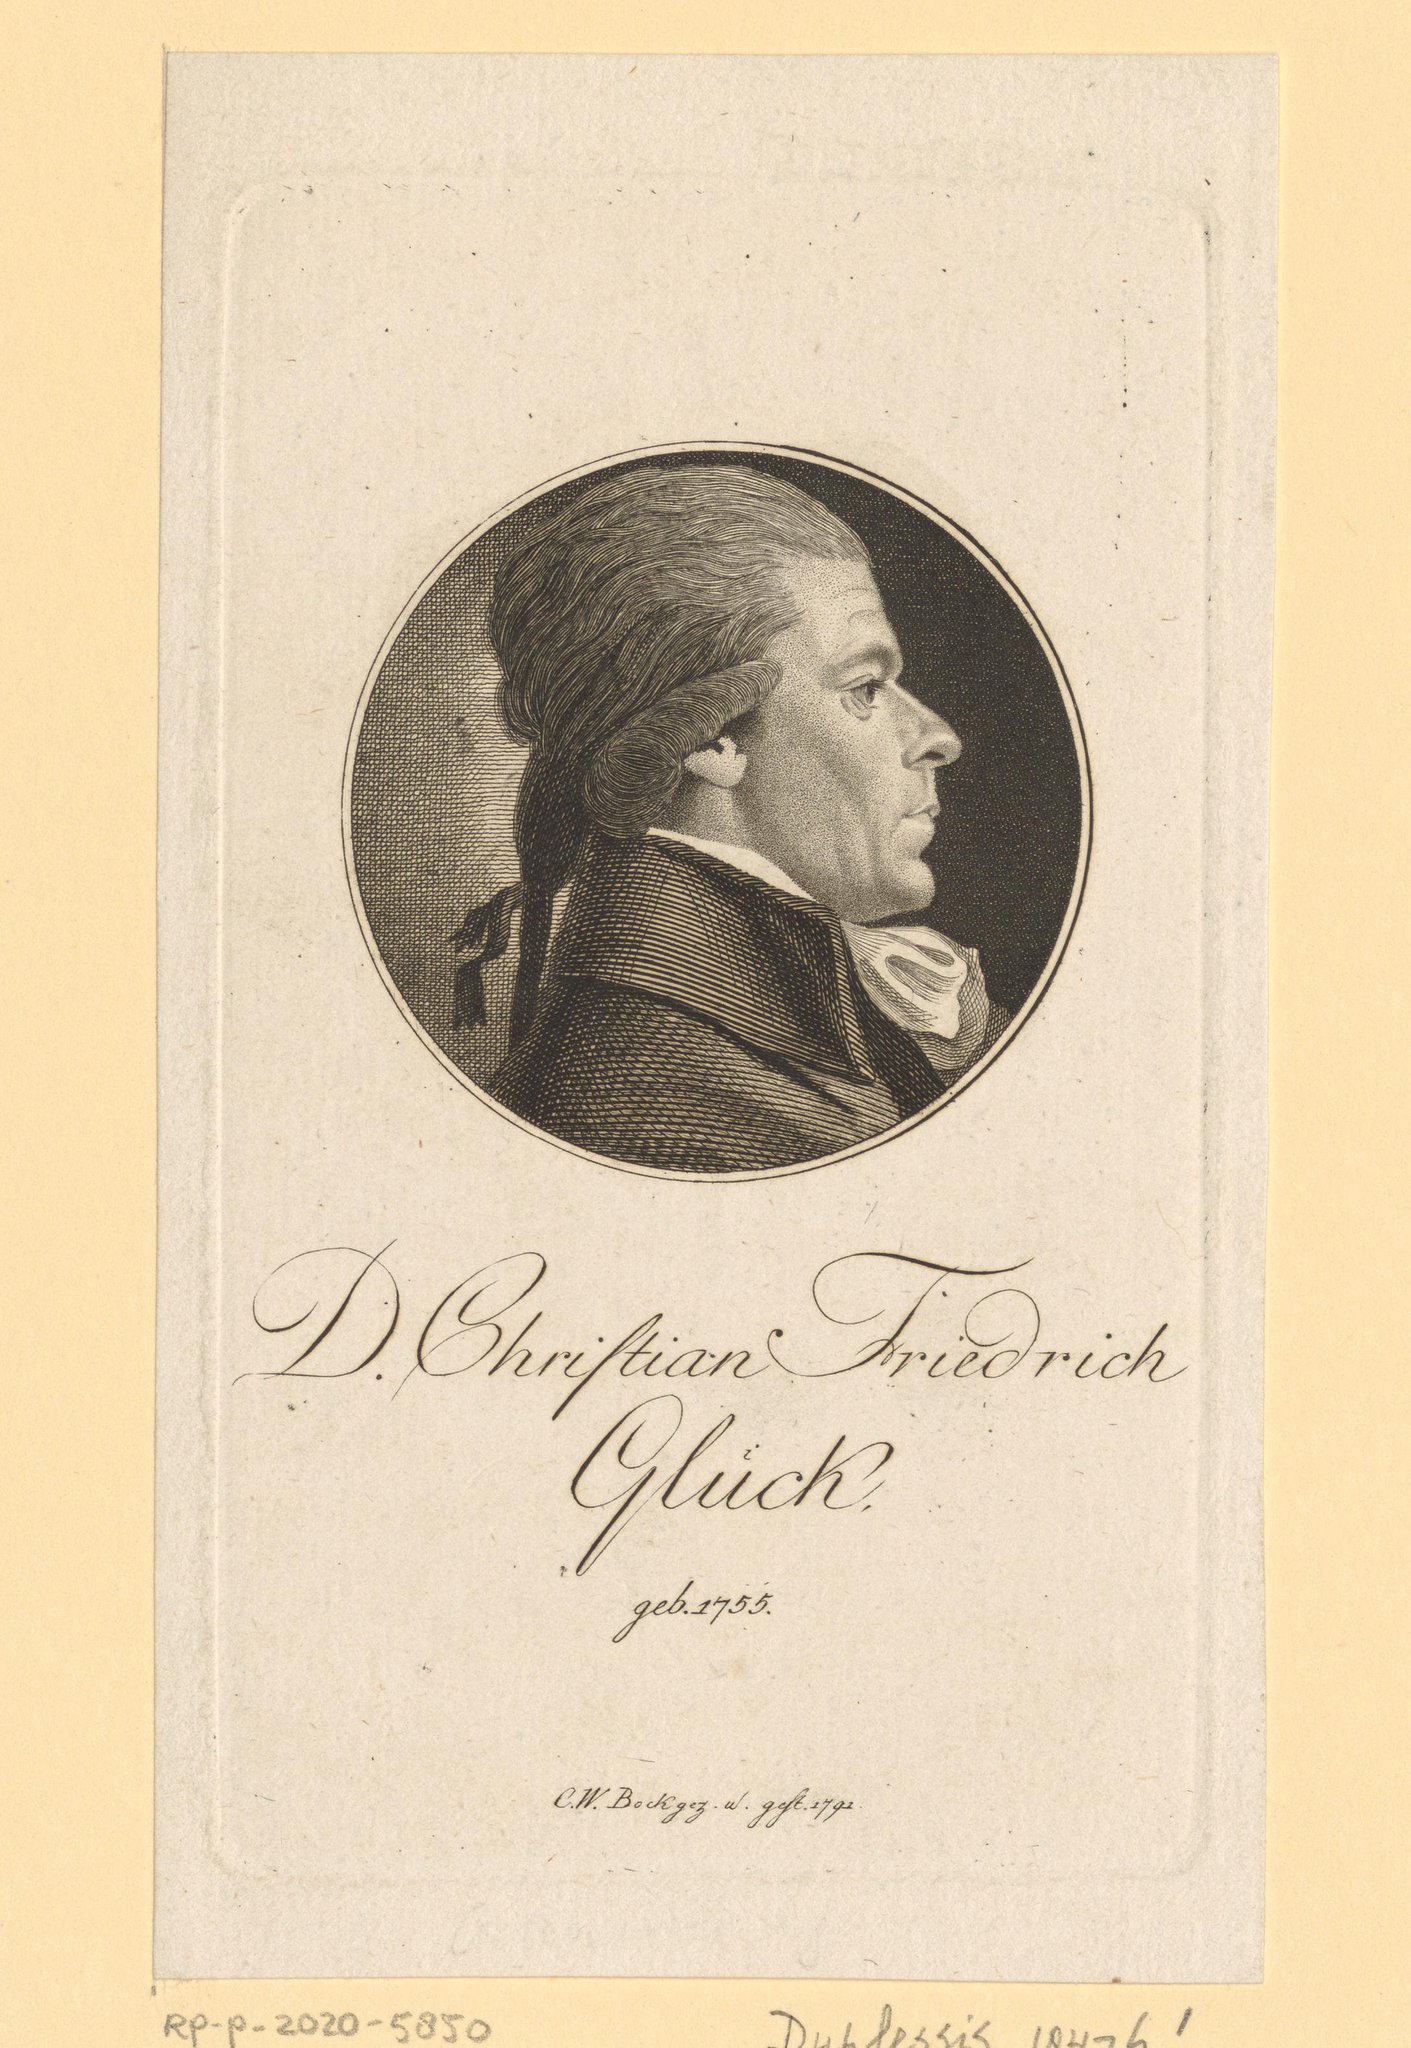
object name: print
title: Portret van Christian Friedrich von Glück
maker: christoph wilhelm bock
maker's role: print maker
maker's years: 1755-1836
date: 1792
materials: paper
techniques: engraving, etching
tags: historical persons, professor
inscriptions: date